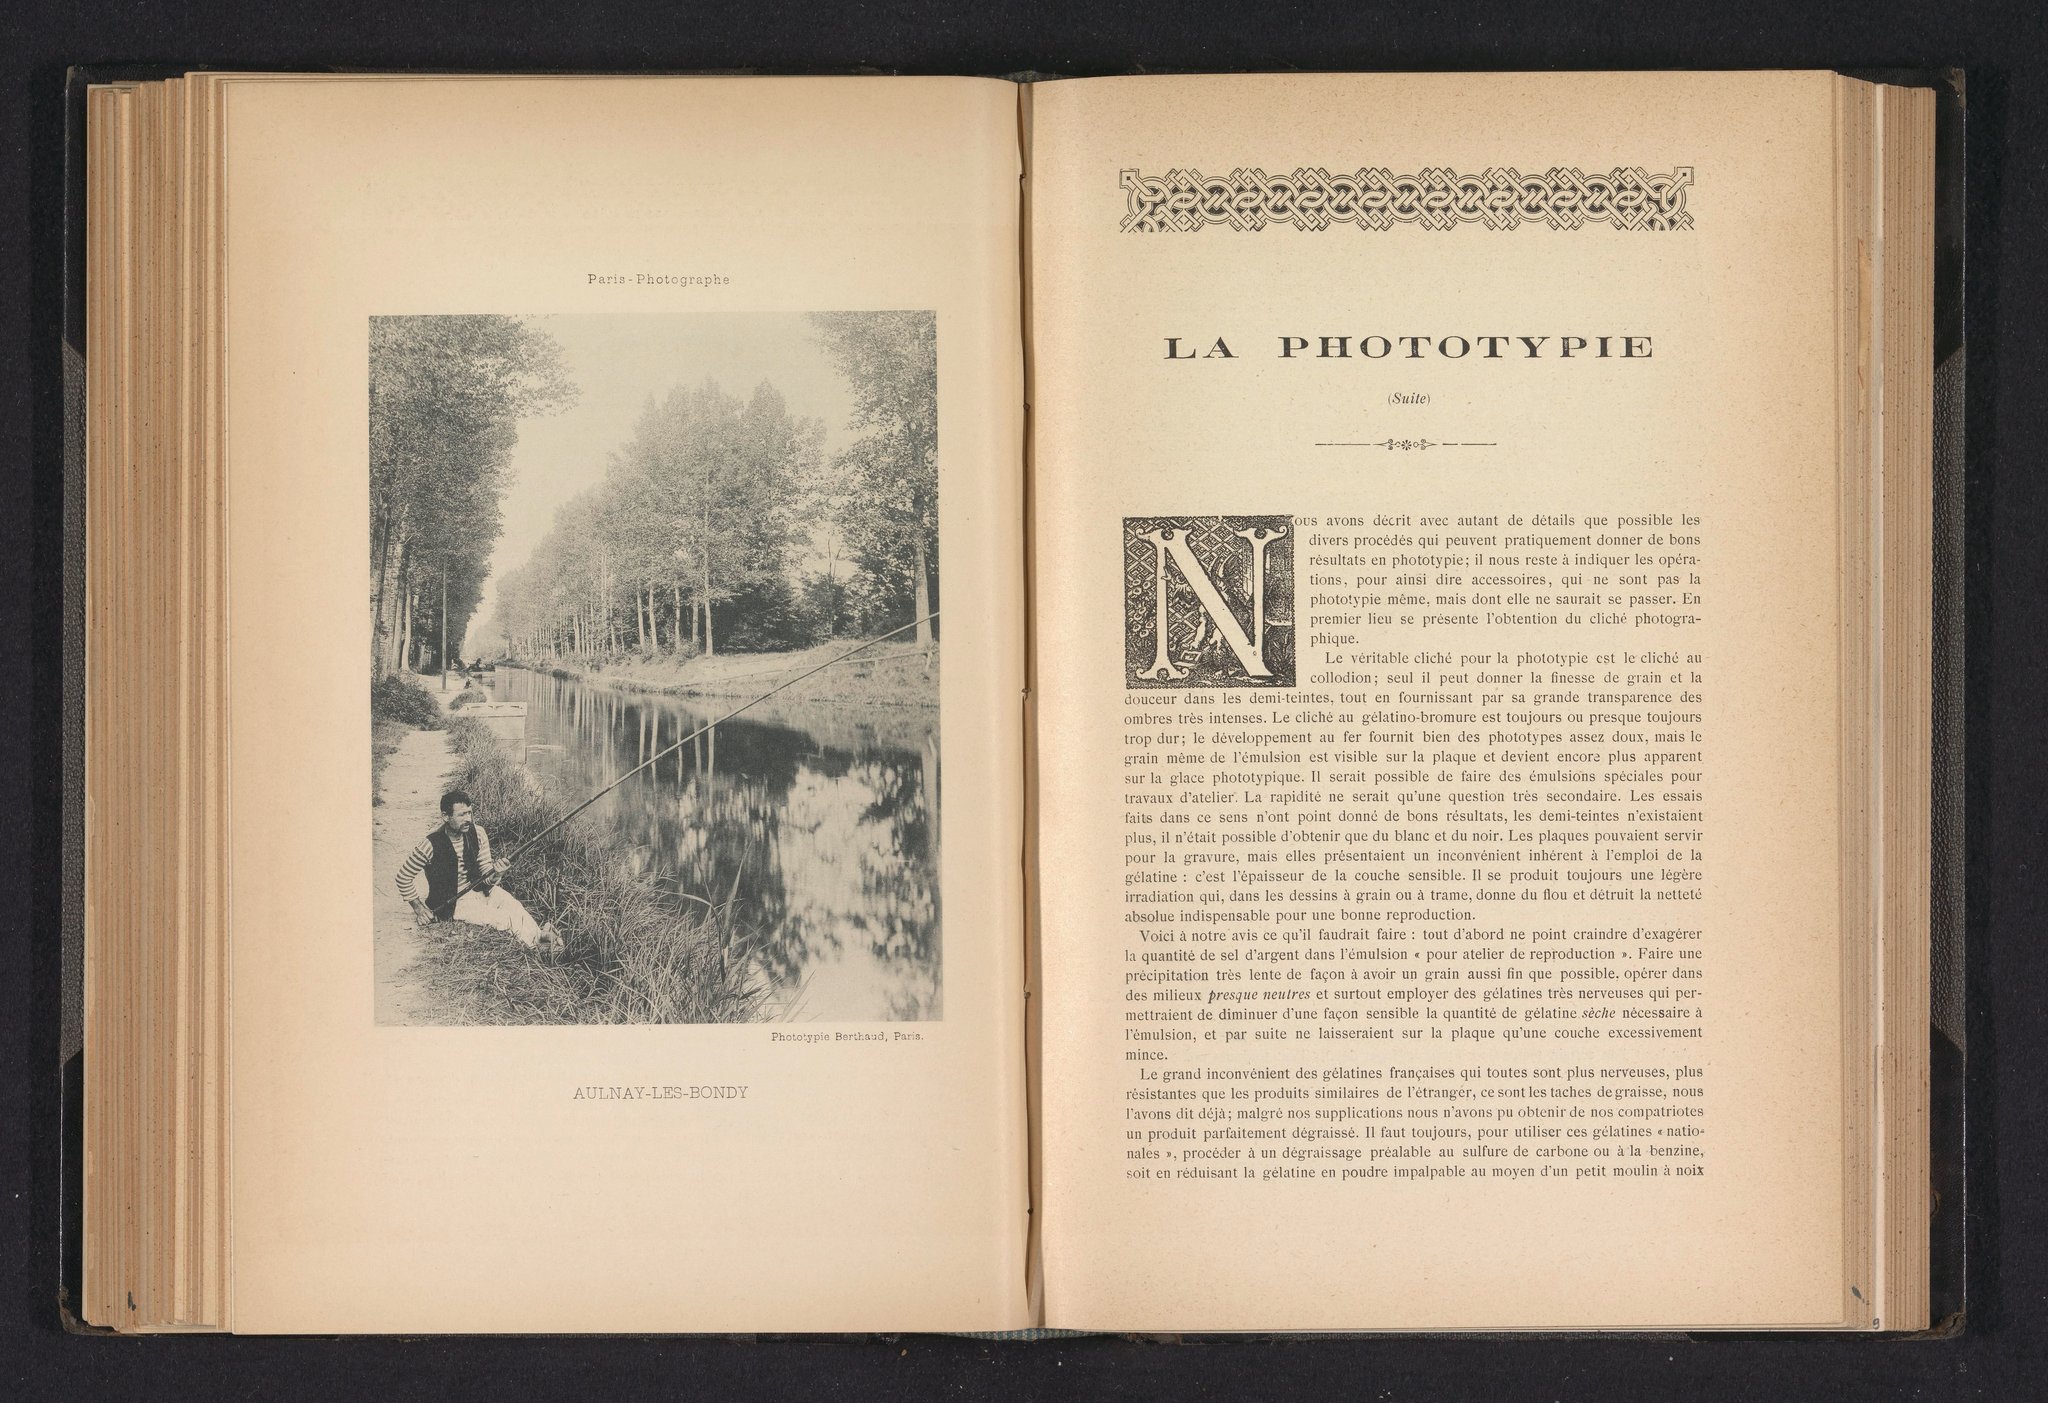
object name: page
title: Visser in Aulnay-sous-Bois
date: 1884-1894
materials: paper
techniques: photograph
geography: france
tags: fisherman